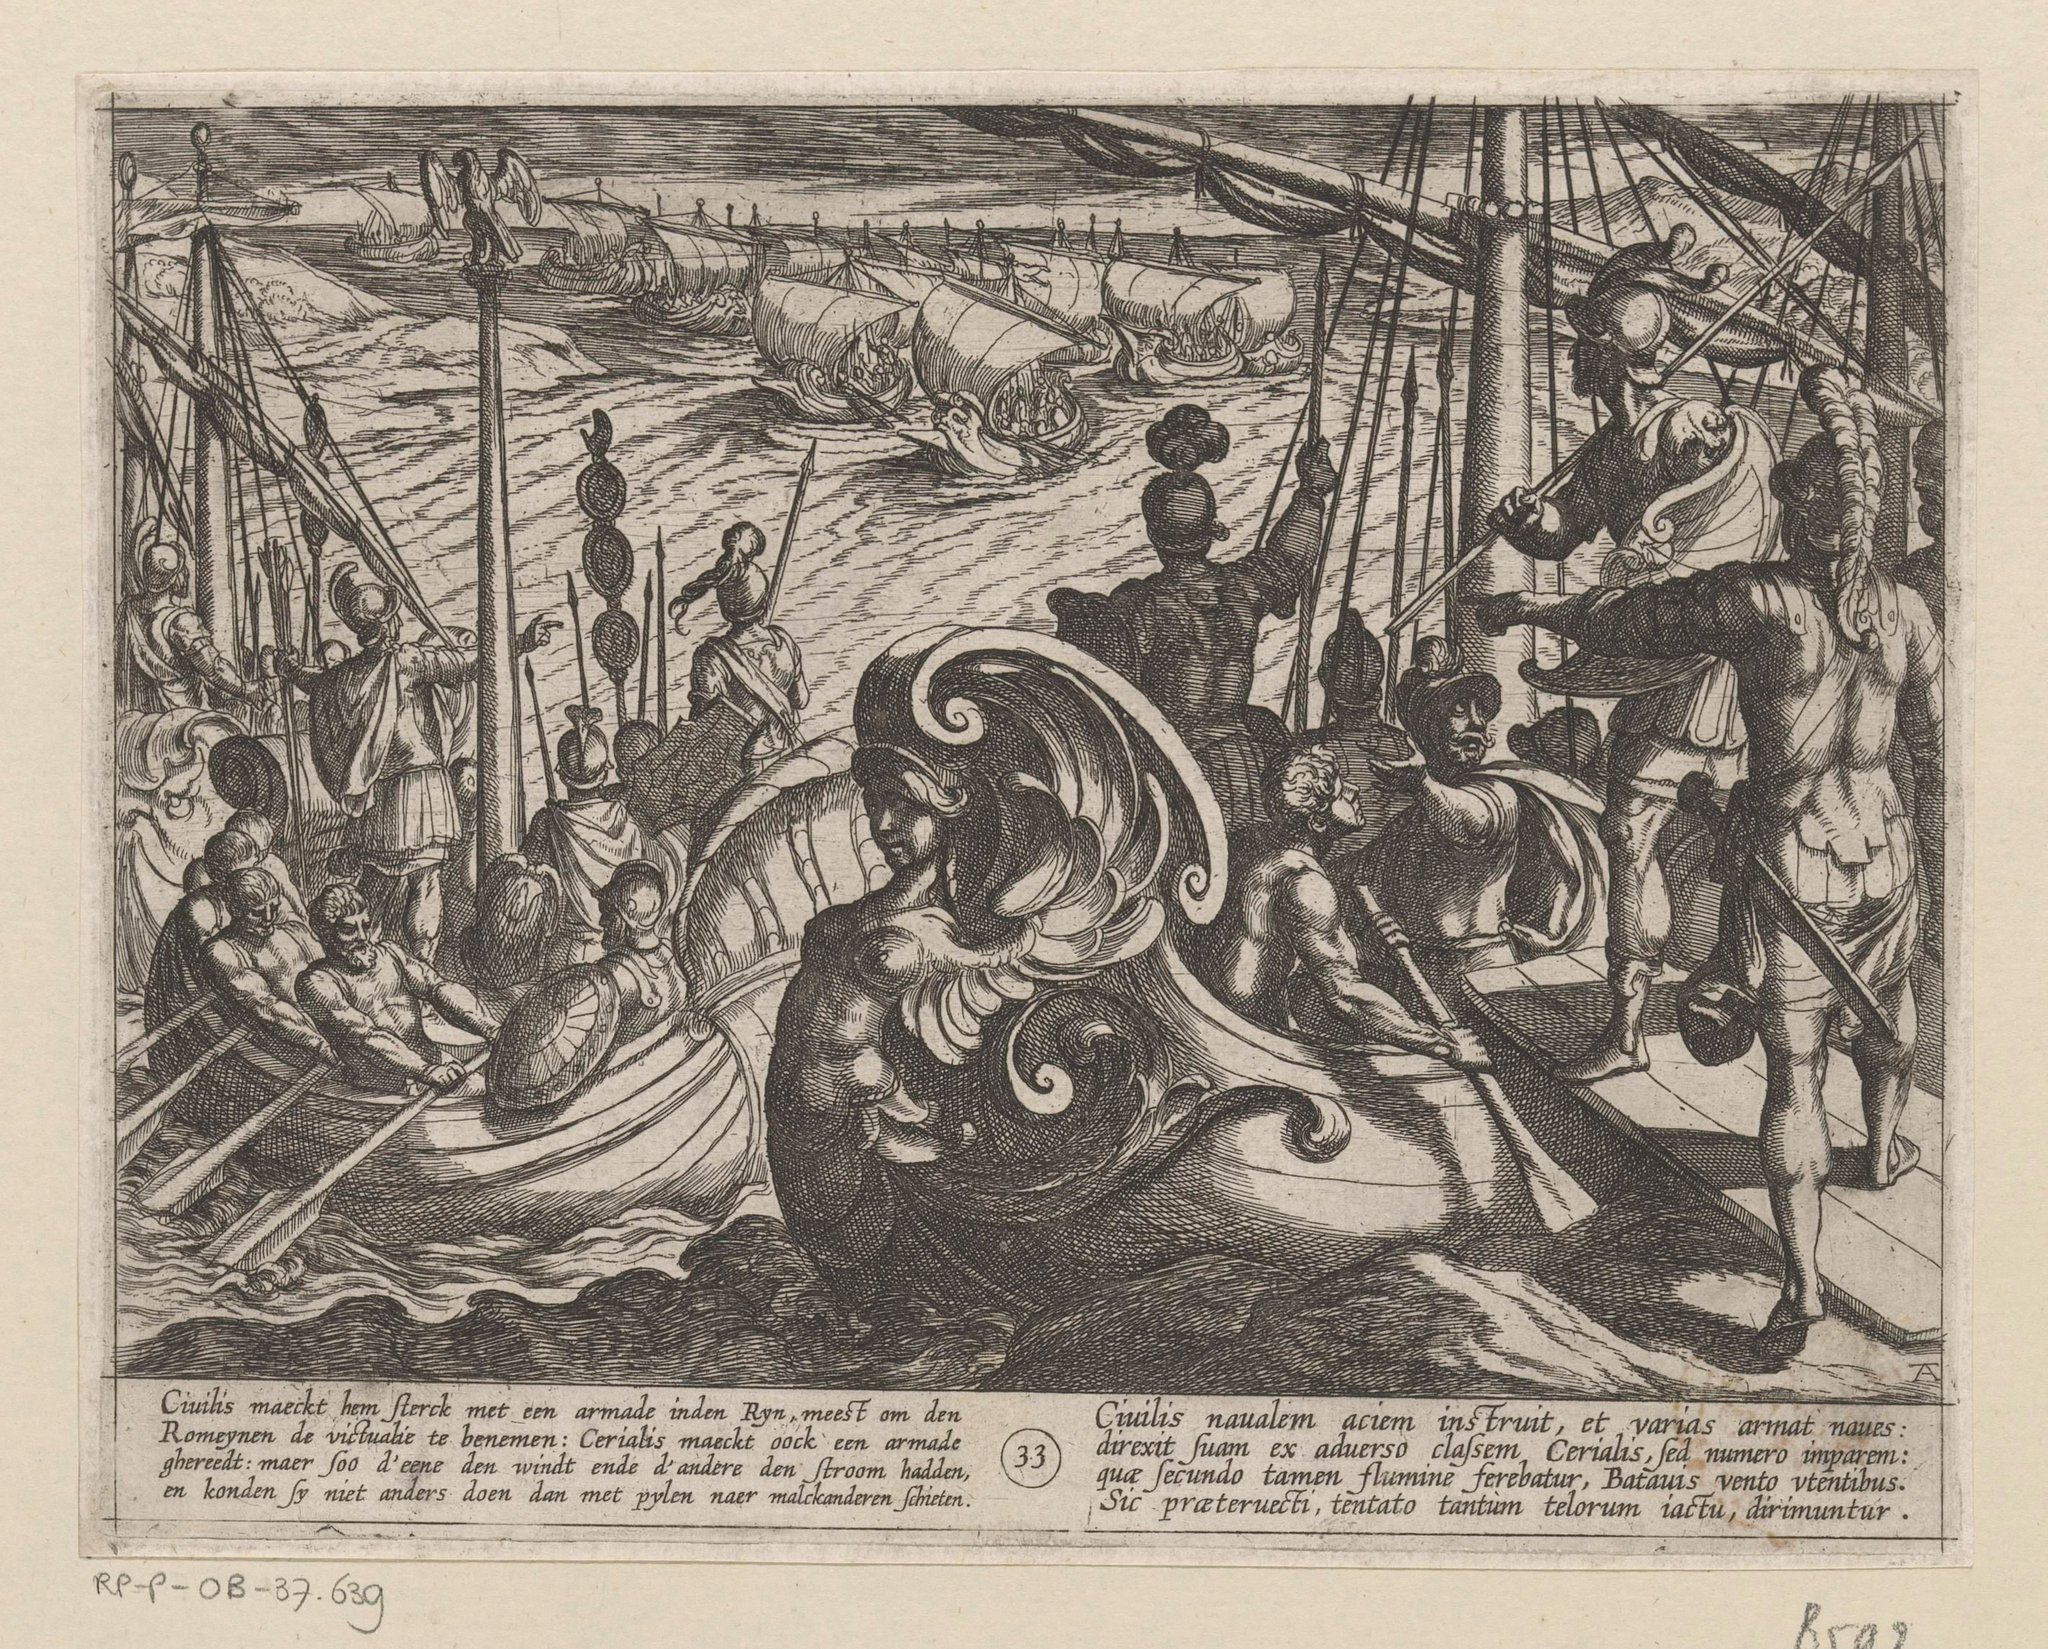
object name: print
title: Batavorum cum Romanis Bellum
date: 1611-1612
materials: paper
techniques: etching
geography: italy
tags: the soldier; the soldier's life, ships (in general) - cc - more than one ship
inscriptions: collector's mark: Lugt 240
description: Deze prent maakt deel uit van een reeks van 36 prenten (+ titelpagina) over de oorlogen tussen de Romeinen en de Bataven.